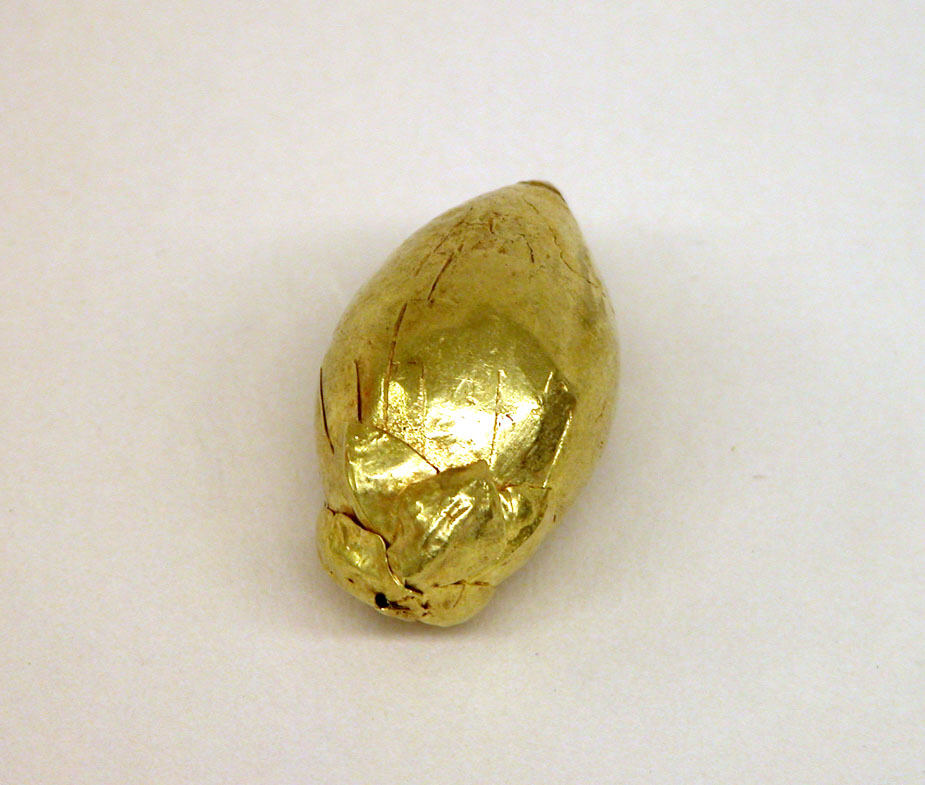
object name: ornament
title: Ornament in Shape of a Lotus Bud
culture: indonesian, javanese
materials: gold